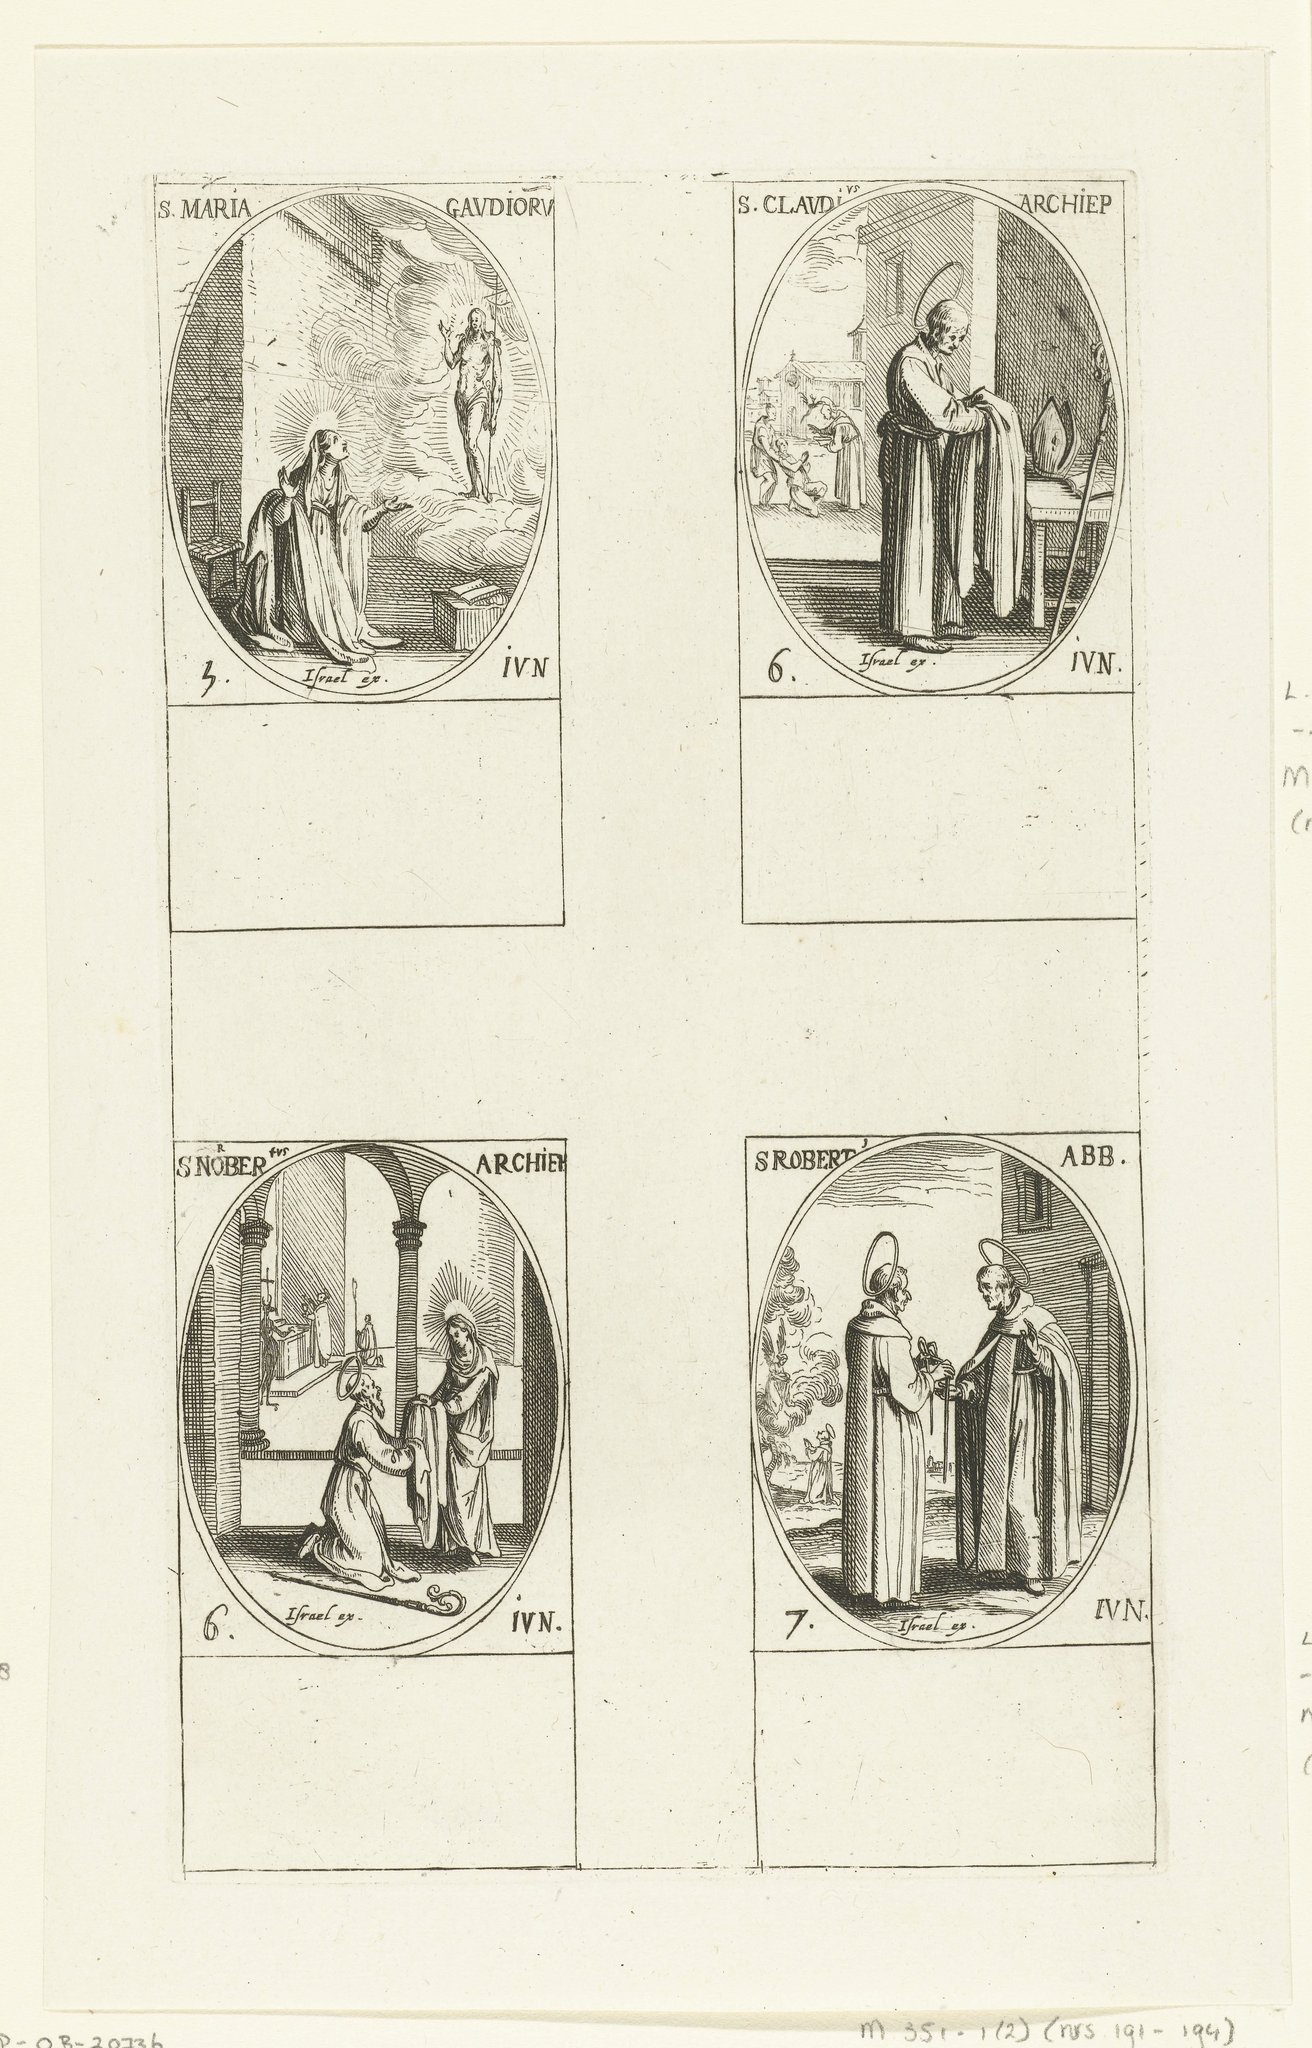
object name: print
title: Alle heiligen en de Christelijke feestdagen van het jaar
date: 1632-1636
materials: paper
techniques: etching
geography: nancy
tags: adult christ with mary, male saints (with name), the virgin mary gives st. norbert a scapular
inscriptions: collector's mark: Lugt 240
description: Blad met vier ovale voorstellingen, elk met opschrift en datum in het Latijn: linksboven Maria geknield voor de herrezen Christus, rechtsboven de Heilige Claudius van Besançon die zijn bisschopskleed aflegt, linksonder de Heilige Norbertus van Magdeburg die van Maria kleding ontvangt, rechtsonder de Heilige Robertus van Newminster met een andere heilige in gesprek. Deze prent is onderdeel van een serie prenten met voorstellingen van de heiligen en de christelijke feestdagen van het jaar. Er zijn steeds vier scènes van één plaat op één blad gedrukt. Inclusief bijbehorend titelblad en frontispice gaat het in totaal om 124 platen (490 voorstellingen). De drie platen met de laatste 12 scènes (de veranderlijke christelijke feestdagen) zijn in de derde staat versneden tot 12 kleine plaatjes, en met een apart titelblad uitgegeven.